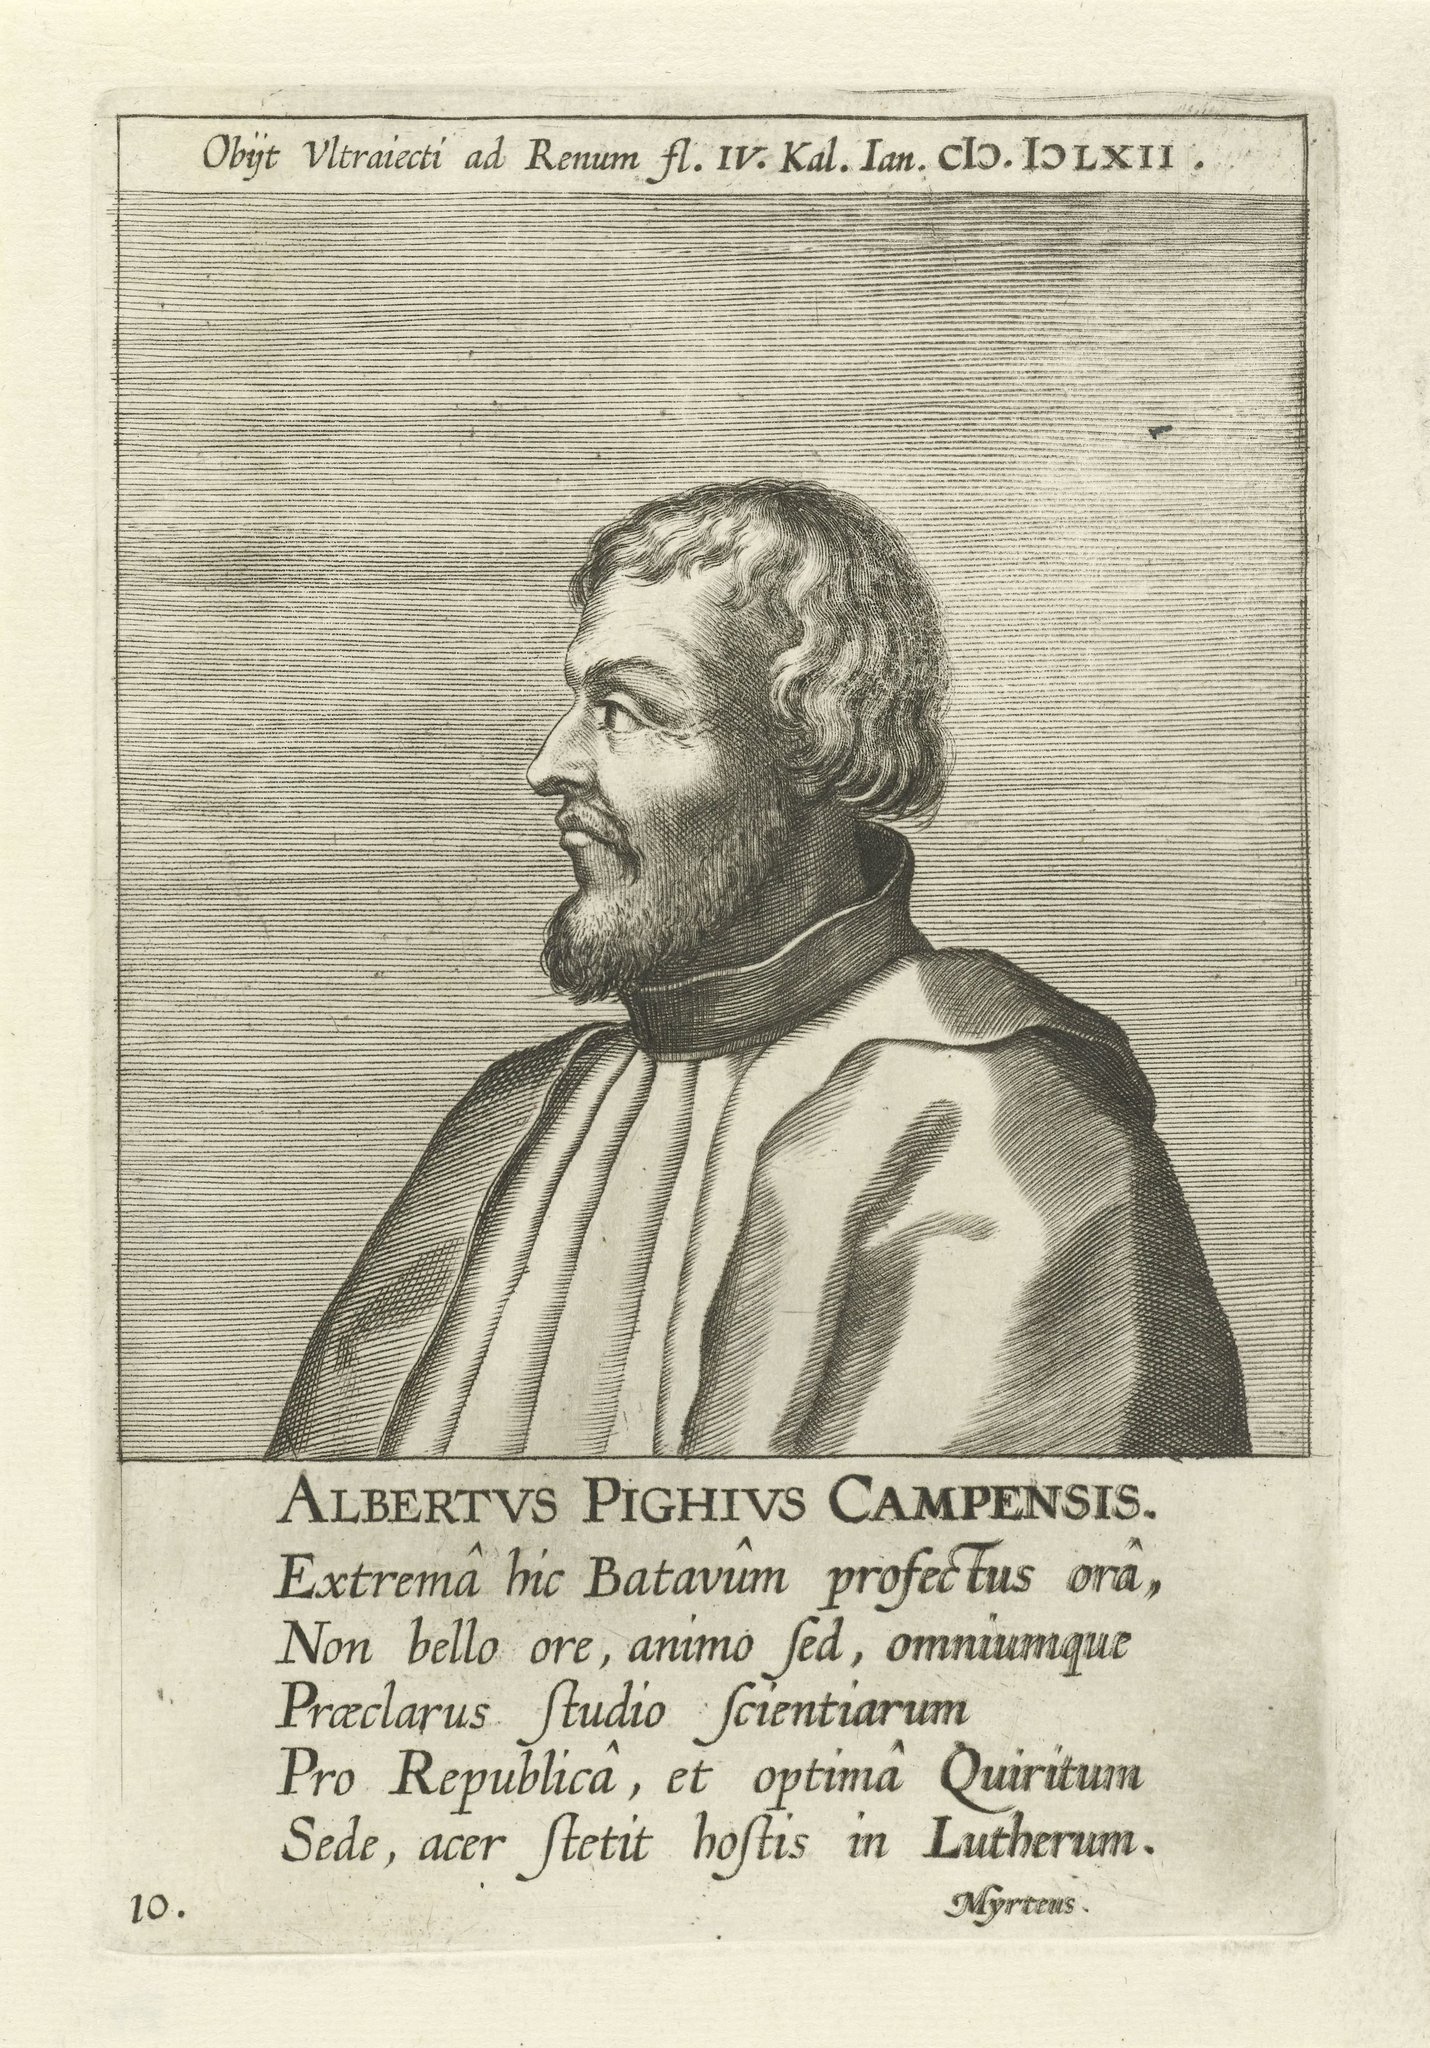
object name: print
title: Illustrium Galliae Belgicae scriptorum icones et elogi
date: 1604-1608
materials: paper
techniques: engraving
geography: antwerp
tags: historical persons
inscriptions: collector's mark: Lugt 2228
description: Portret van Albert Pigge, Nederlandse astronoom en theoloog in dienst van Paus Adriaan VI. In profiel naar links. De prent heeft een Latijns boven- en onderschrift en maakt deel uit van een serie van beroemde Nederlandse en Vlaamse geleerden.